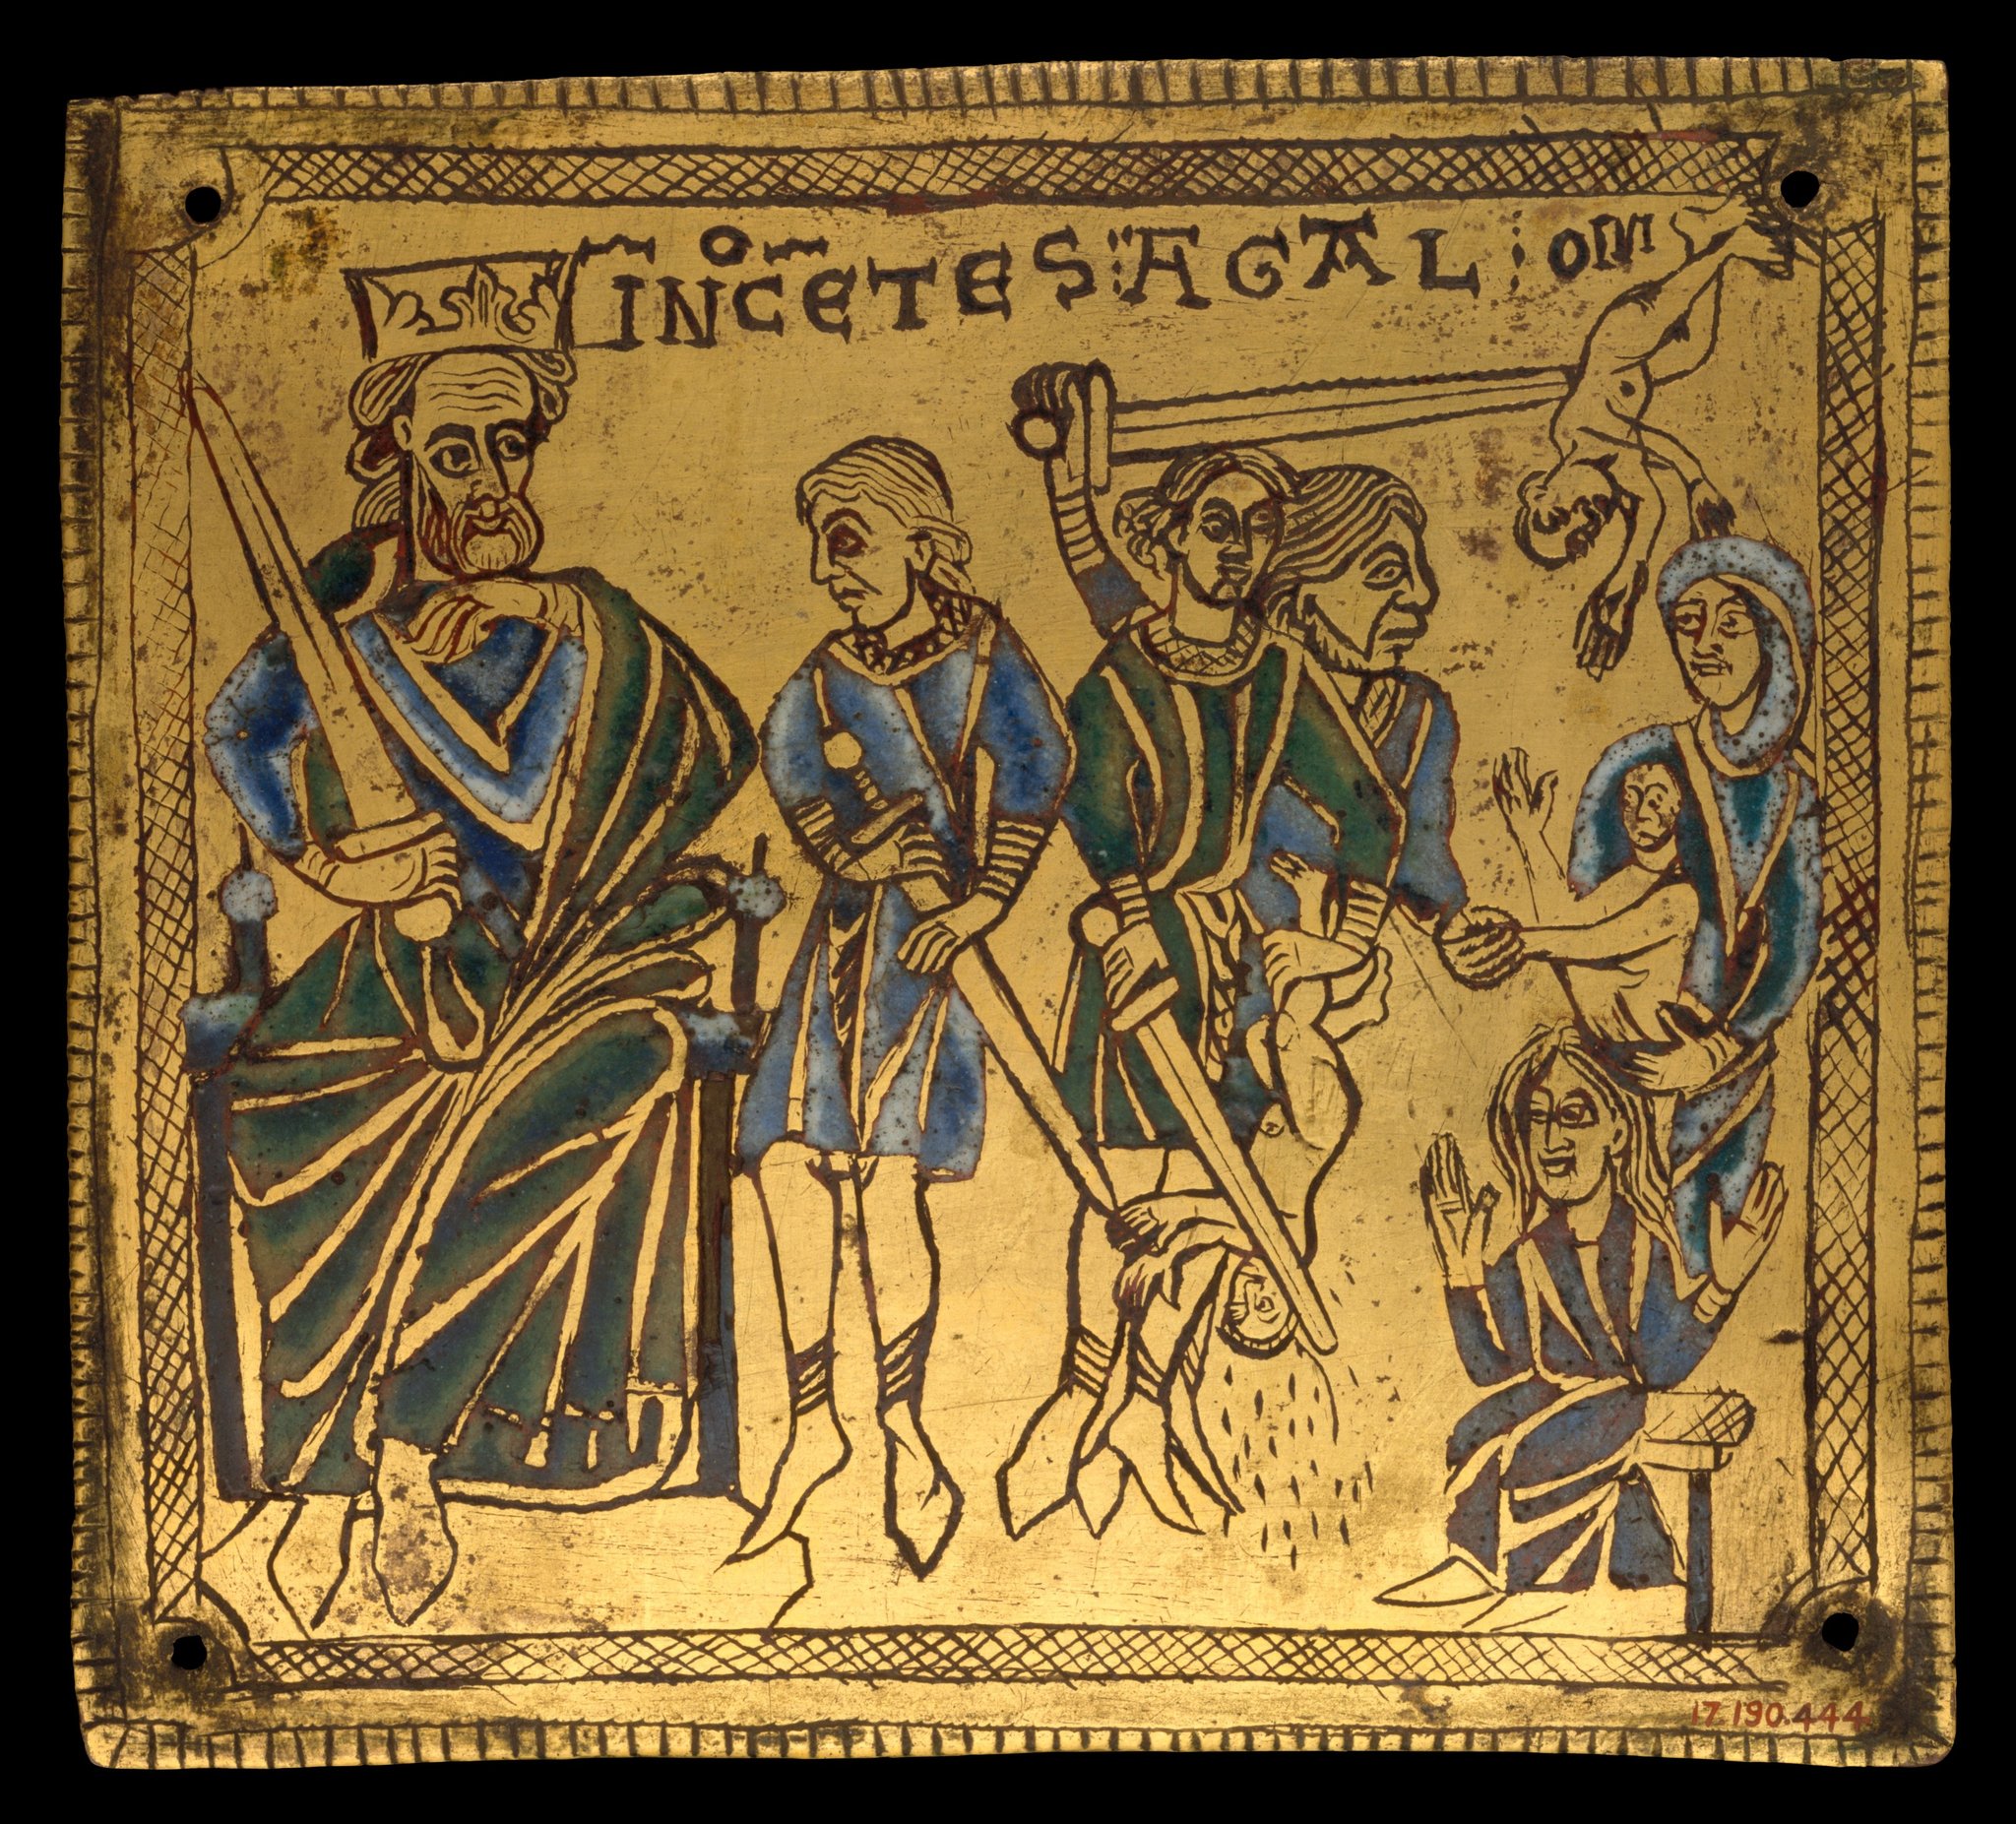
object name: plaque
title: Plaque with the Massacre of the Innocents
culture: german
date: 1150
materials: gilt copper, enamel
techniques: enamel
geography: germany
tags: swords,kings,men,women